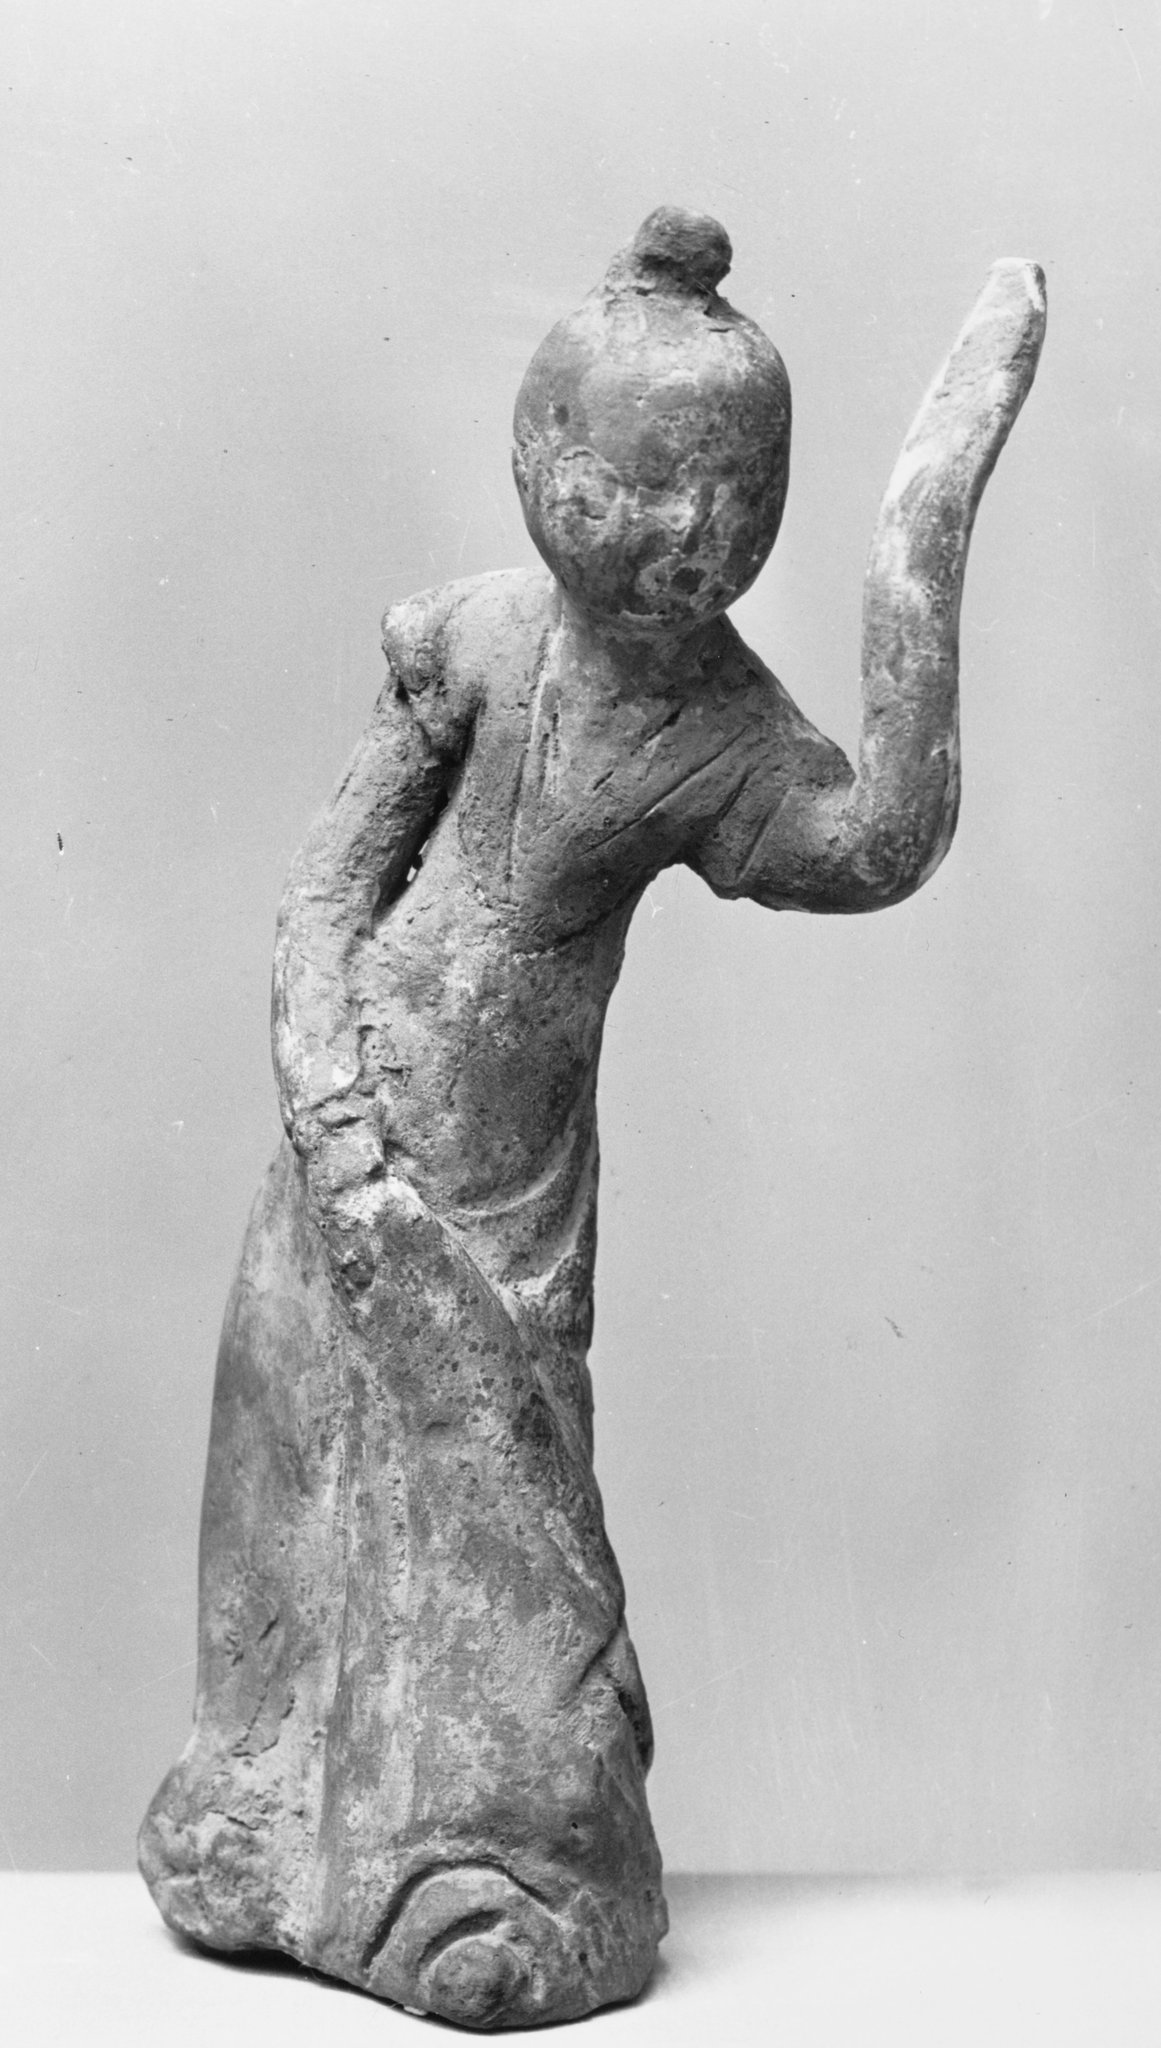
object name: figure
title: Female dancer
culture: chinese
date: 601-800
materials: earthenware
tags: human figures